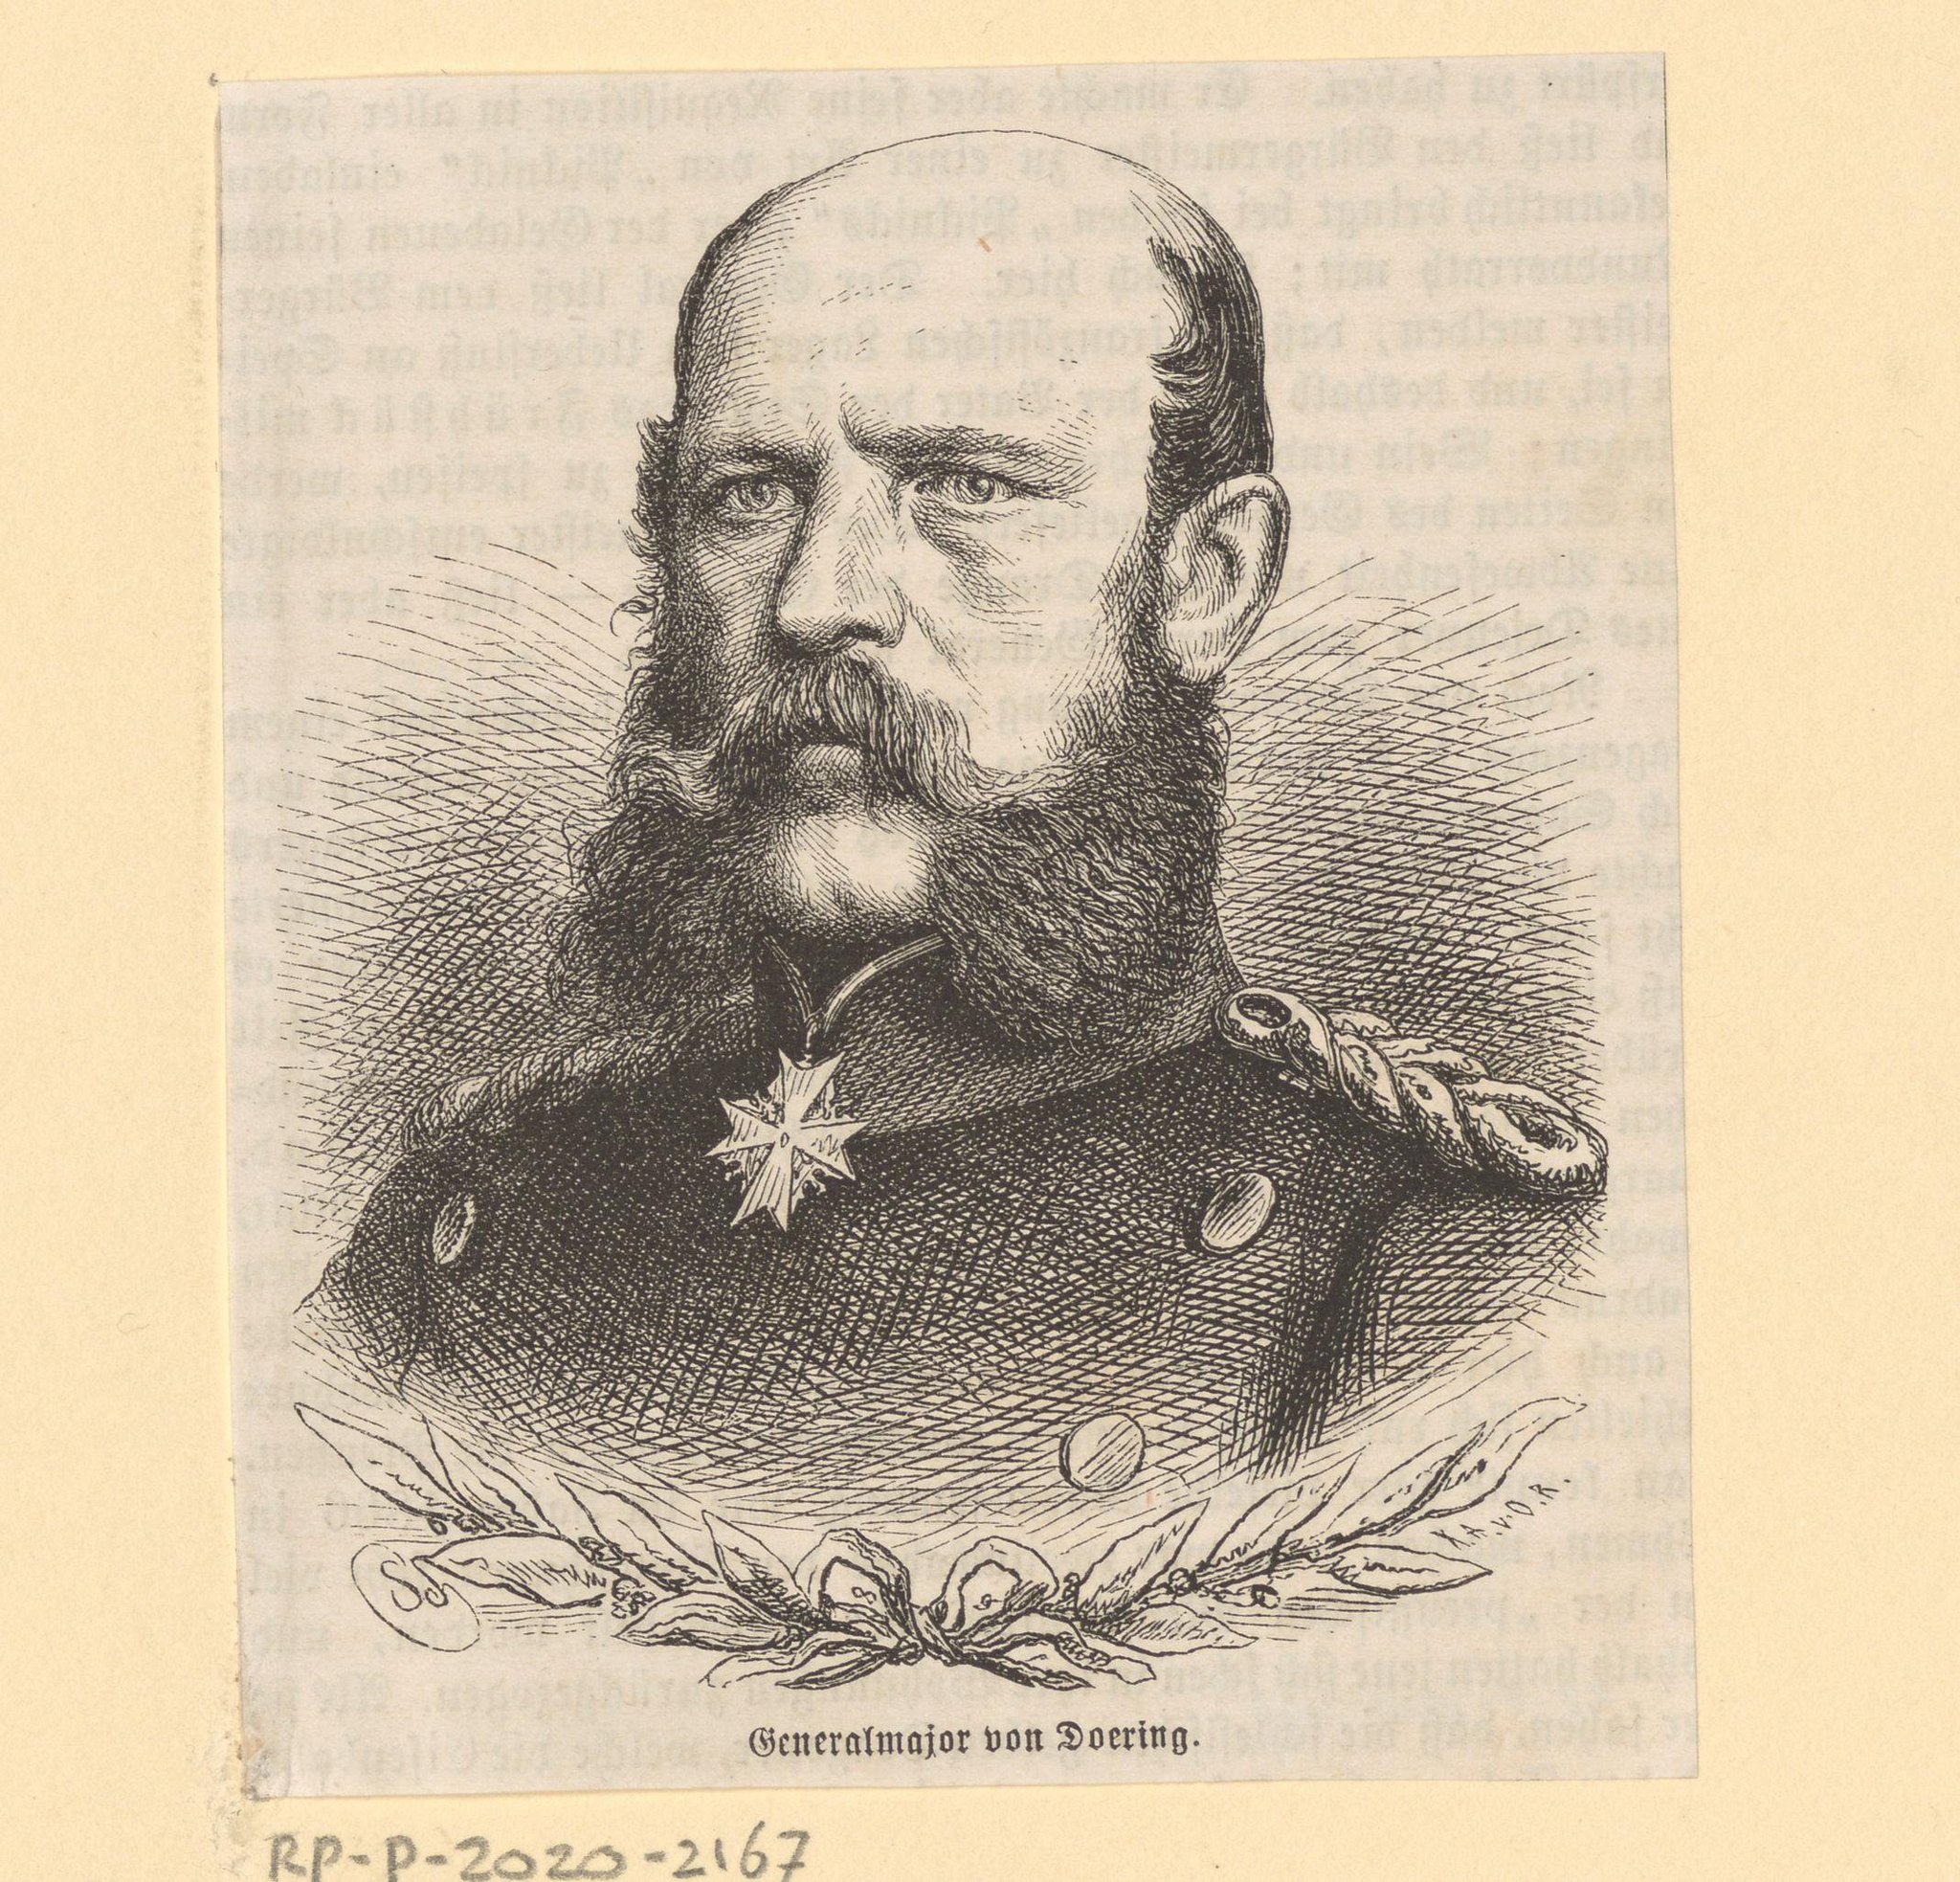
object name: photomechanical print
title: Portret van Wilhelm von Doering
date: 1870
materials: paper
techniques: letterpress printing, printing block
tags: commander-in-chief, general, marshal, historical persons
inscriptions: stamp: ‘JVB’, monogram: ‘SJ’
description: Prent uit: Daheim 6 (1870), nr. 50, 10 september 1870.